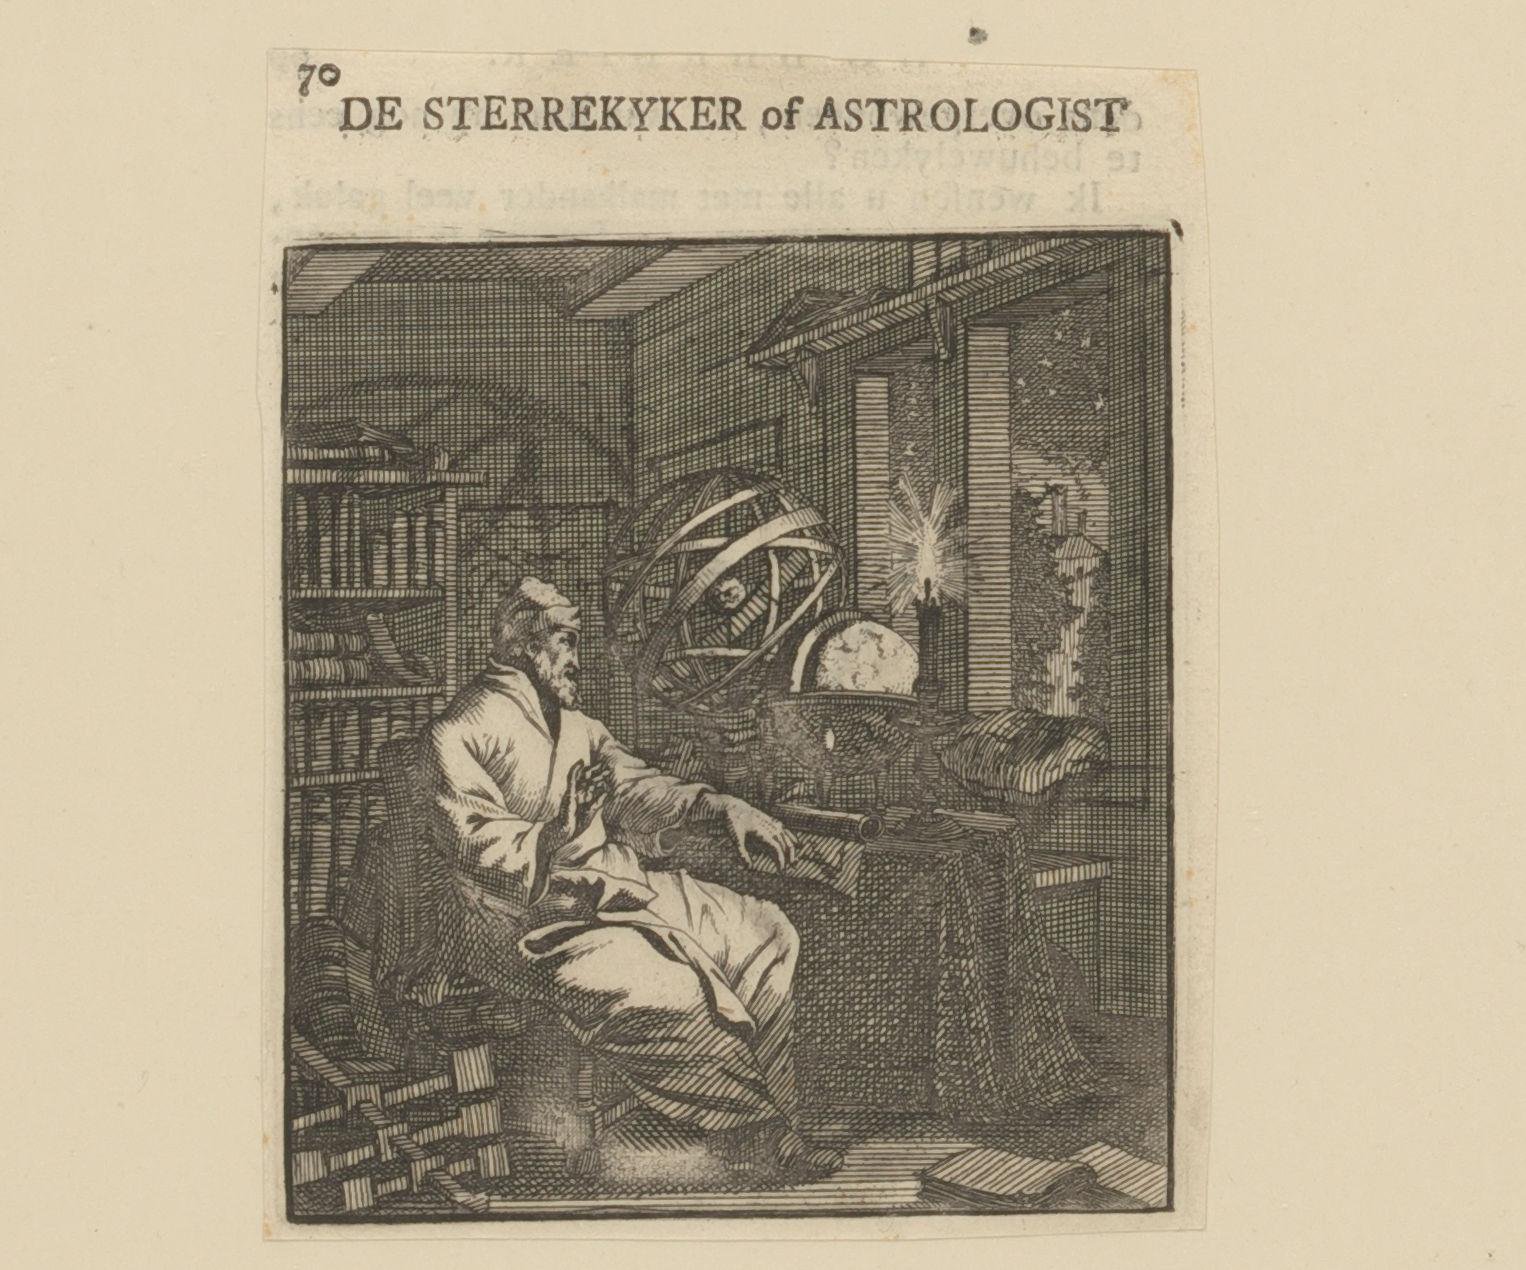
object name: print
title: De Sterrekyker of Astrologist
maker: Anonymous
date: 1719-1759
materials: paper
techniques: etching, letterpress printing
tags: astrologer observing the heavens, astrologer at work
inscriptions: stamp, collector's mark: Lugt 1641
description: Prent met andere letterzetting gebruikt in: St. Clara, Abraham van. Iets voor allen. [Vertaald door] J. le Long. Amsterdam: Janssoons van Waesberge, 1719, dl. 2. En in: St. Clara, Abraham van. Iets voor allen. [Vertaald door] J. le Long. Amsterdam: Jan Roman de Jonge, 1741, dl. 2. En in: St. Clara, Abraham van. Iets voor allen. [Vertaald door] J. le Long. Amsterdam: Jan Roman, 1759, dl. 2. Huidige prent uit een andere editie. Naar een prent van: Jan Luyken.